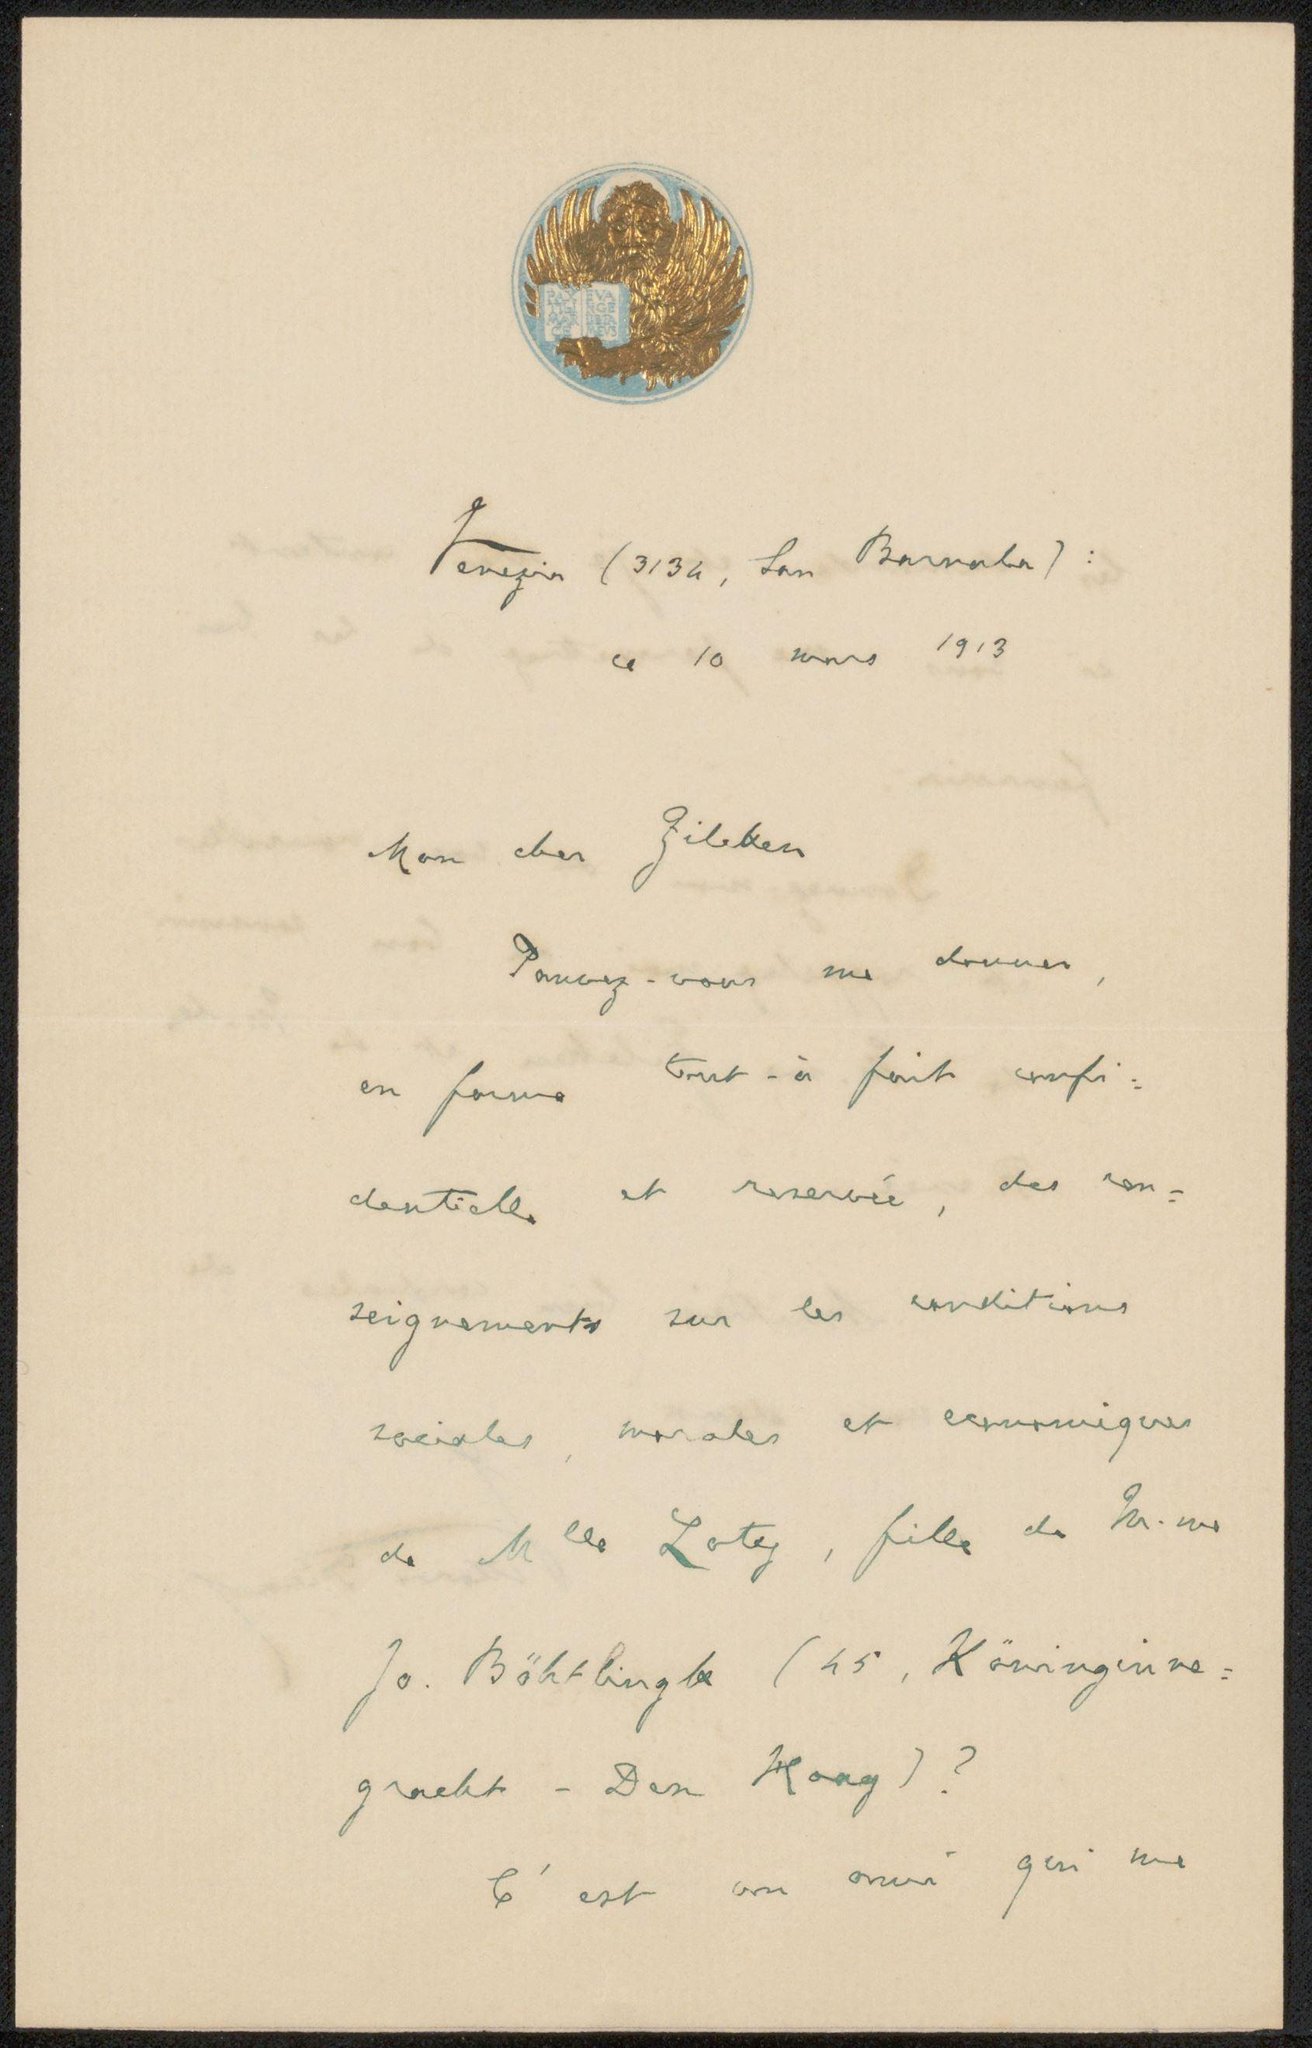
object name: letter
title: Brief aan Philip Zilcken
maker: vittorio pica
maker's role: criticus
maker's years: 1864-1930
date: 1913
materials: ink, paper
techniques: pen, printing, writing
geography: venice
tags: the hague, painter, draughtsman, philip zilcken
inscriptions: watermark, collector's mark: ‘RPK’